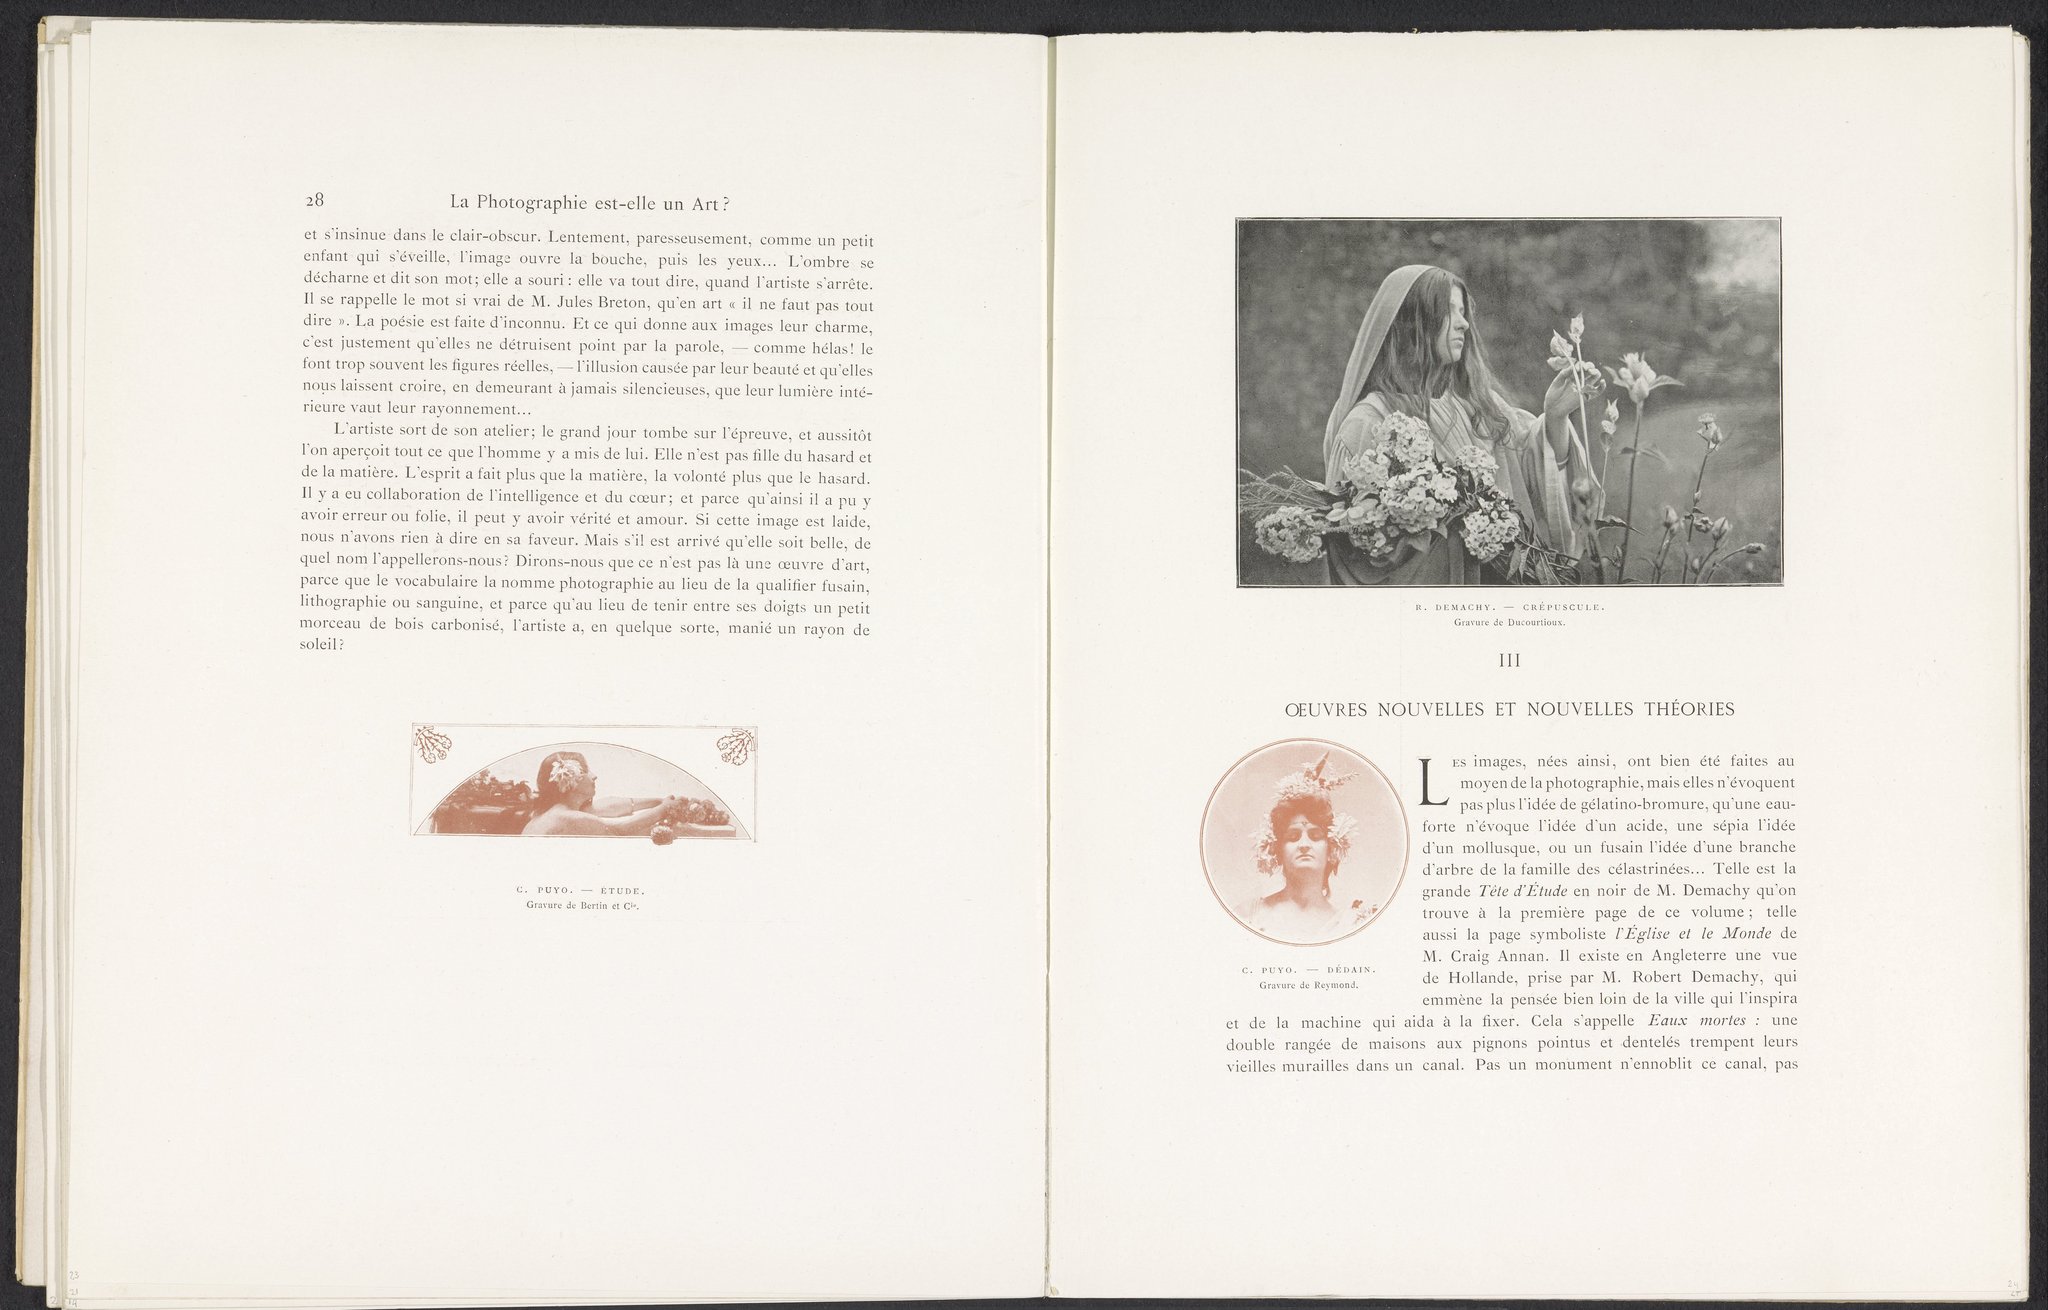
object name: page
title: Twee vrouwen met bloemen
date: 1889-1899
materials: paper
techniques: autotype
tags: picking flowers, flowers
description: Boven: vrouw die bloemen plukt, onder: portret van een onbekende vrouw met bloemen in haar haar.